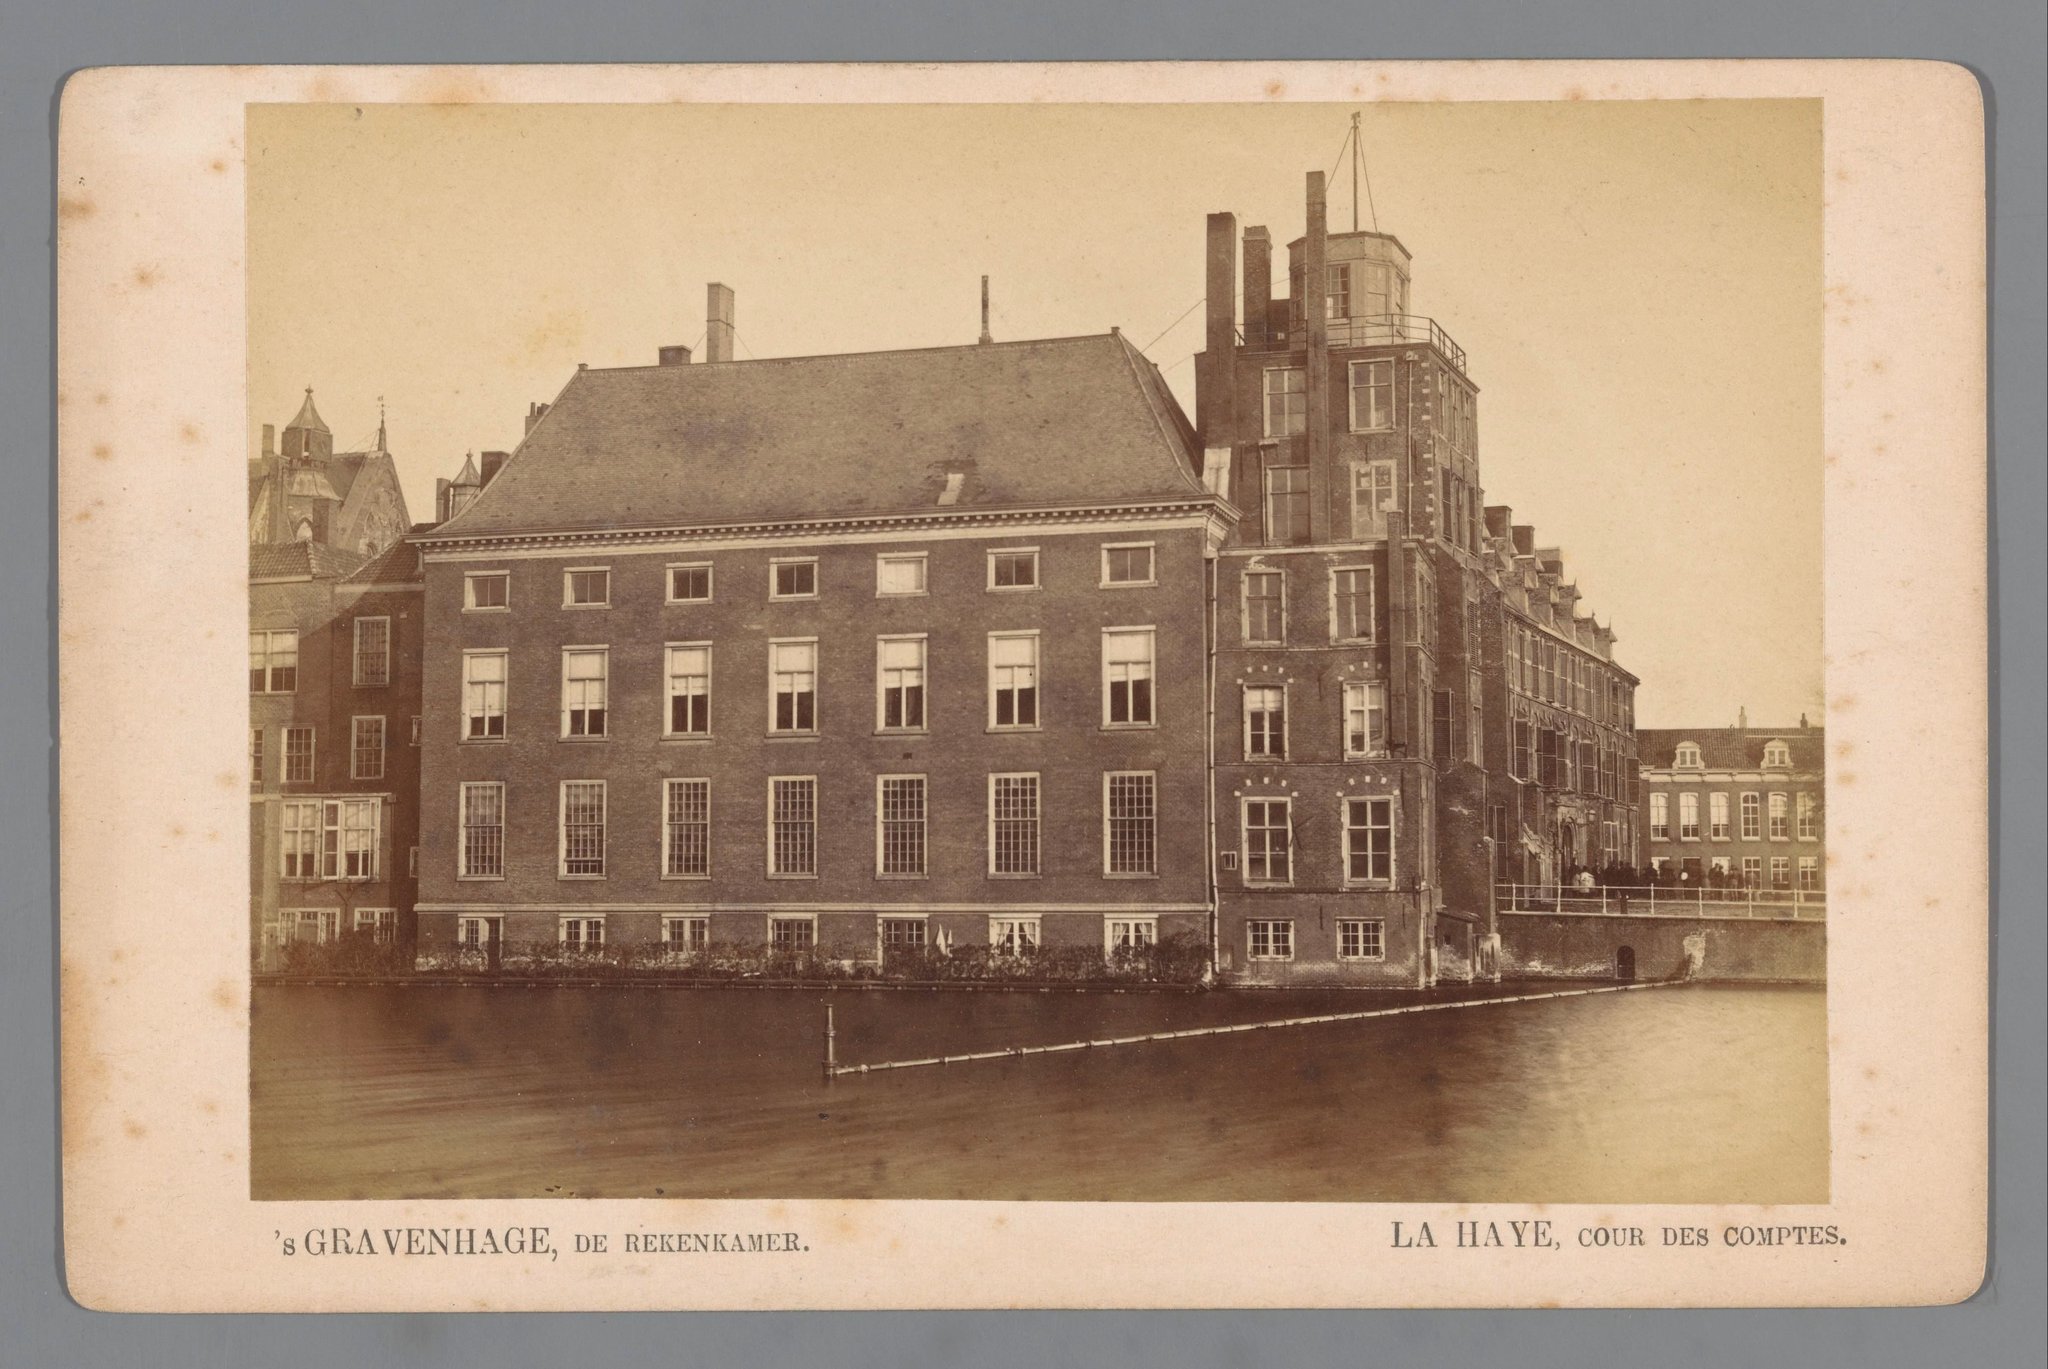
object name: photograph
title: La Haye, Cour des Comptes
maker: Anonymous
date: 1870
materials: cardboard, photographic support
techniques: albumen print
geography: the hague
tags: national government, façade (of house or building)